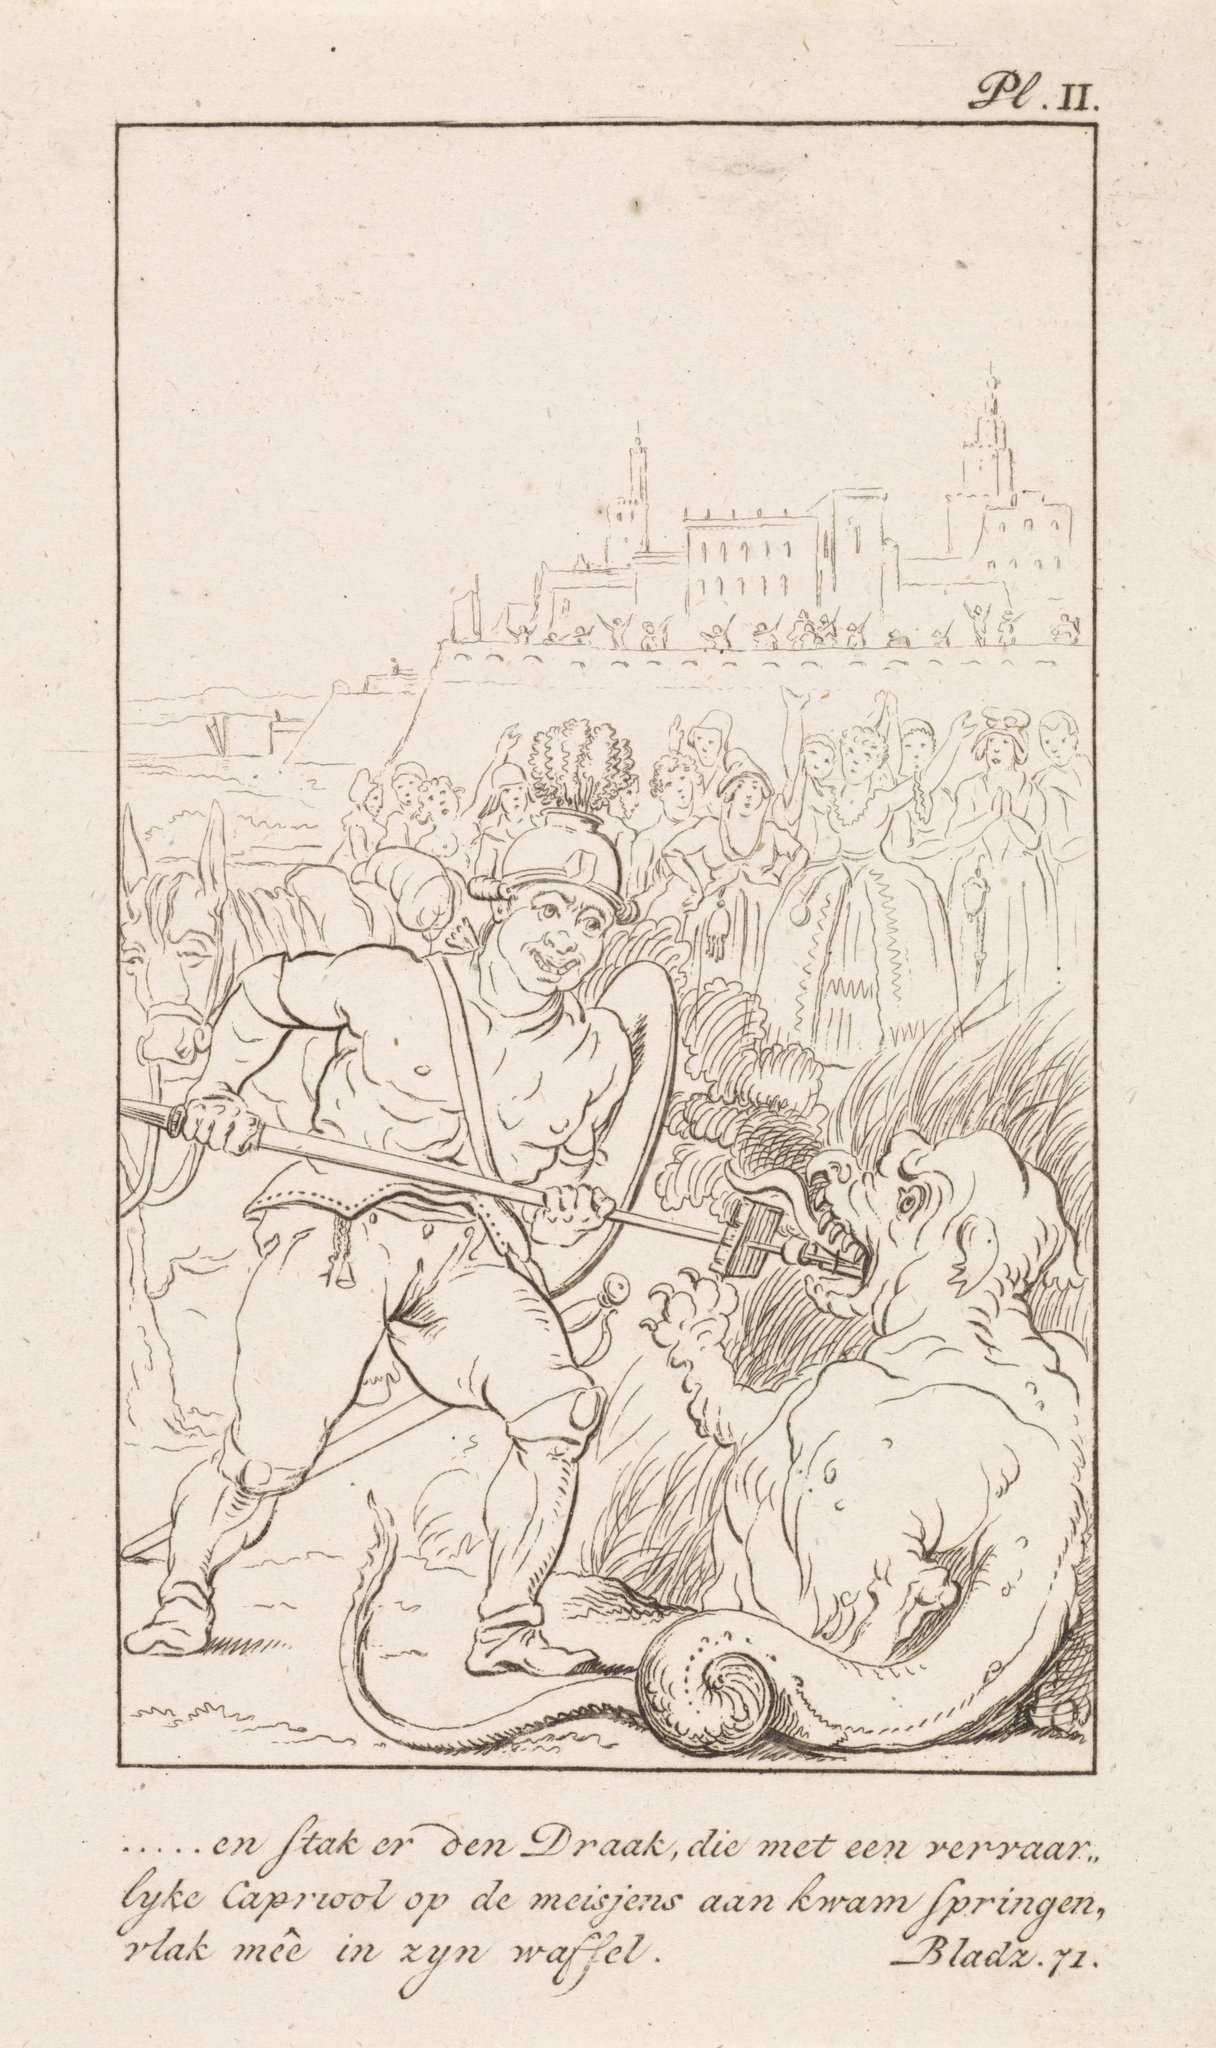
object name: print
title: Man steekt een draak neer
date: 1802-1809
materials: paper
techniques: etching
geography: haarlem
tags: dragon, political caricatures and satires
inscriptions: collector's mark: Lugt 2228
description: Prent als boekillustratie gebruikt in: Fokke Simonsz., Arend. London in een' boertigen stijl beschreeven. Deel III uit: Boertige Reis door Europa. 7 dln. Haarlem: François Bohn, 1802-1809.